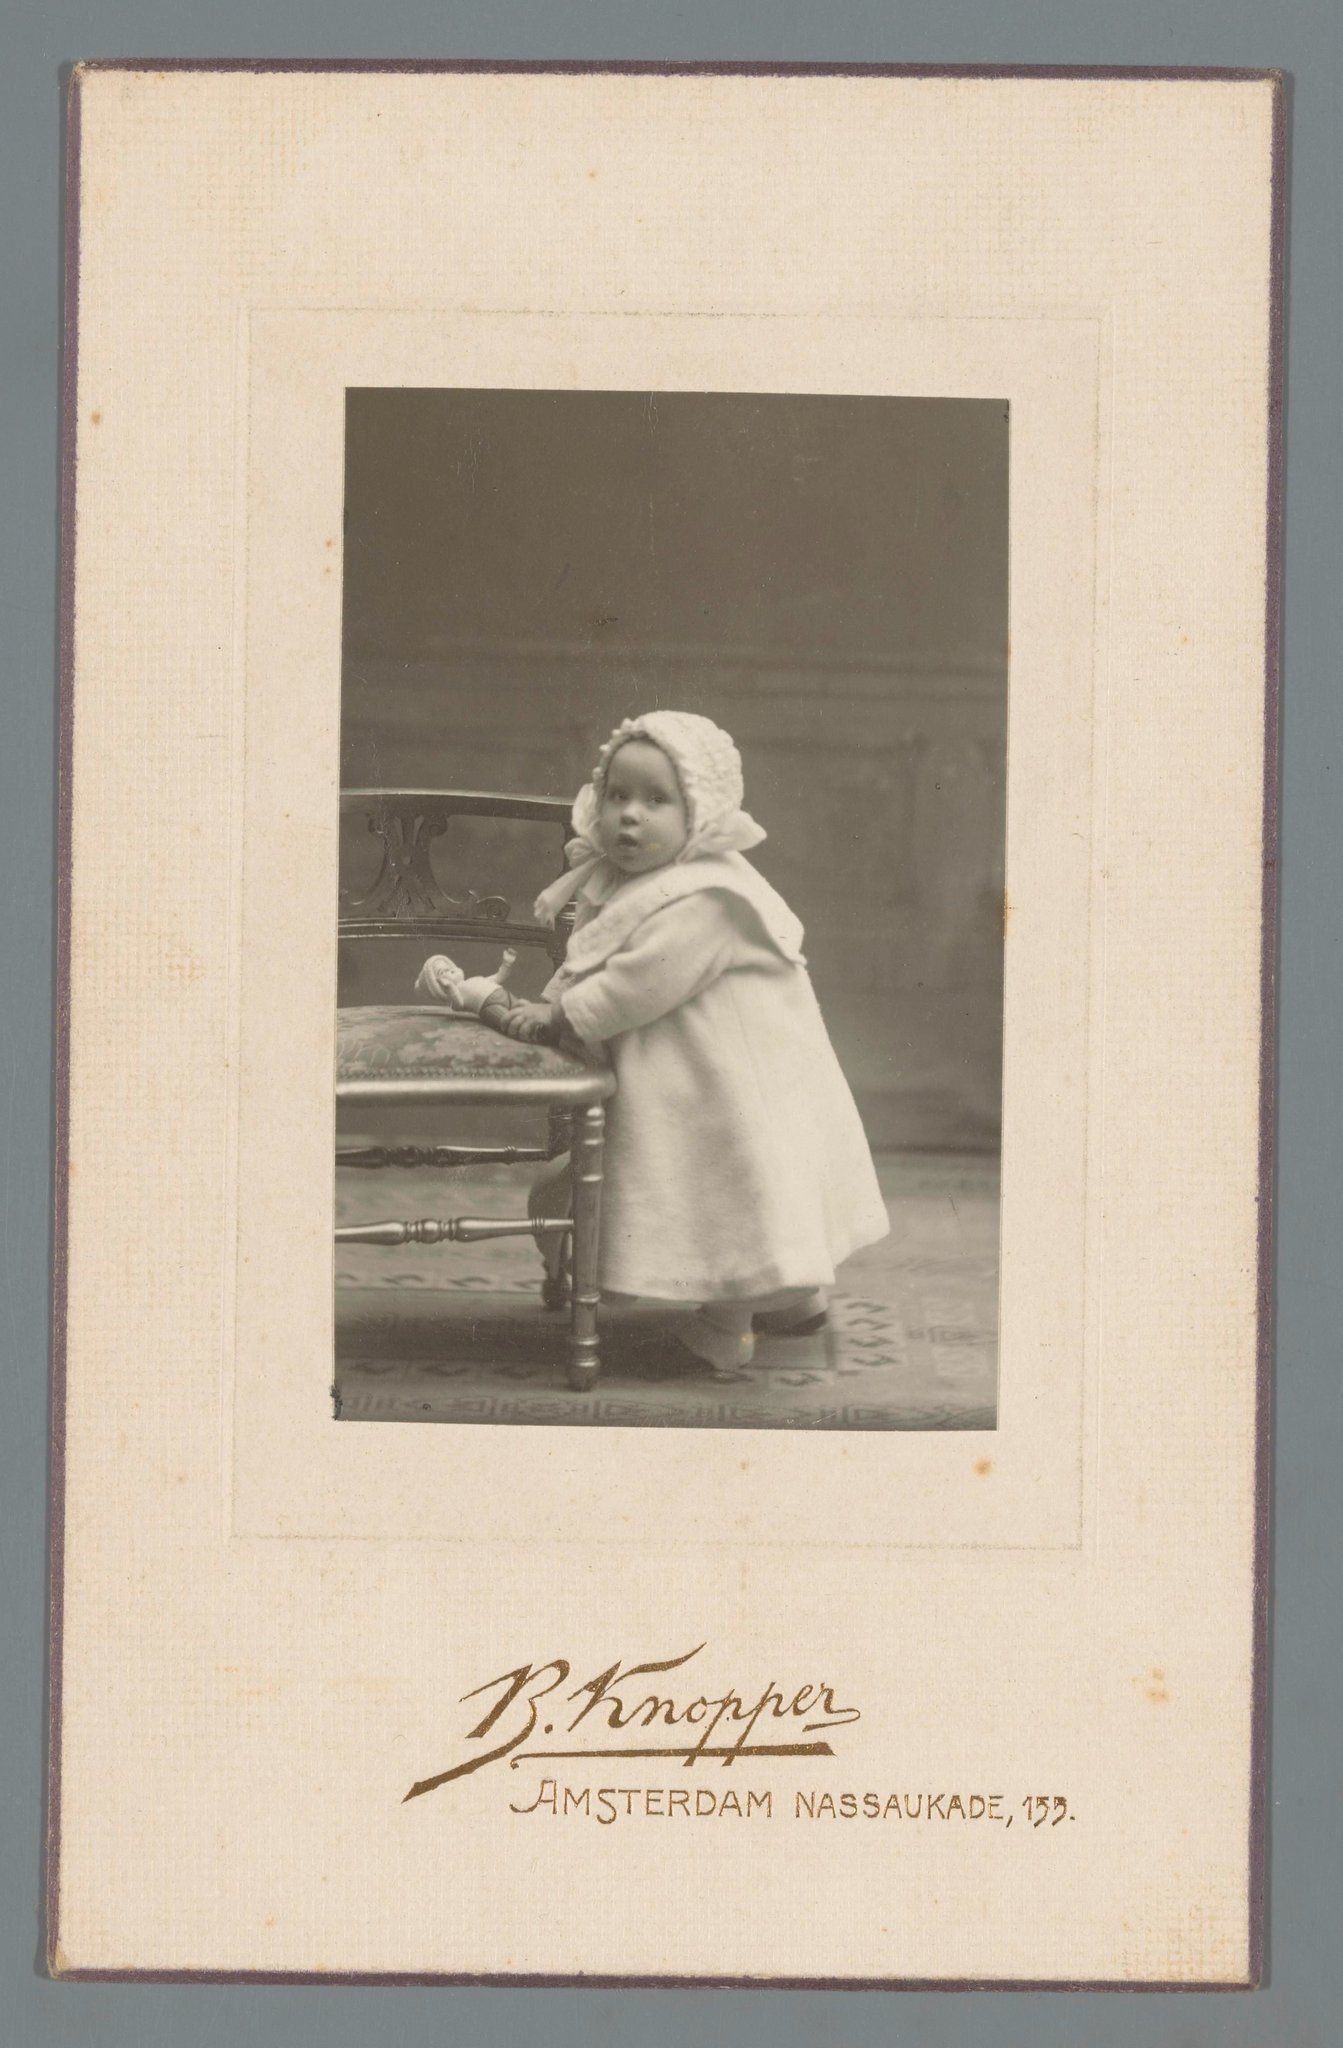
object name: cabinet photograph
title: Portret van een peuter met een pop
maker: b. knopper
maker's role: fotograaf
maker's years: 1870-1932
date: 1905-1915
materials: cardboard, photographic support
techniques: matte daylight collodion silver print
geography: amsterdam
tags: toddler, (playing with) dolls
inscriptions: name: ‘B. Knopper Amsterdam Nassaukade, 155.’